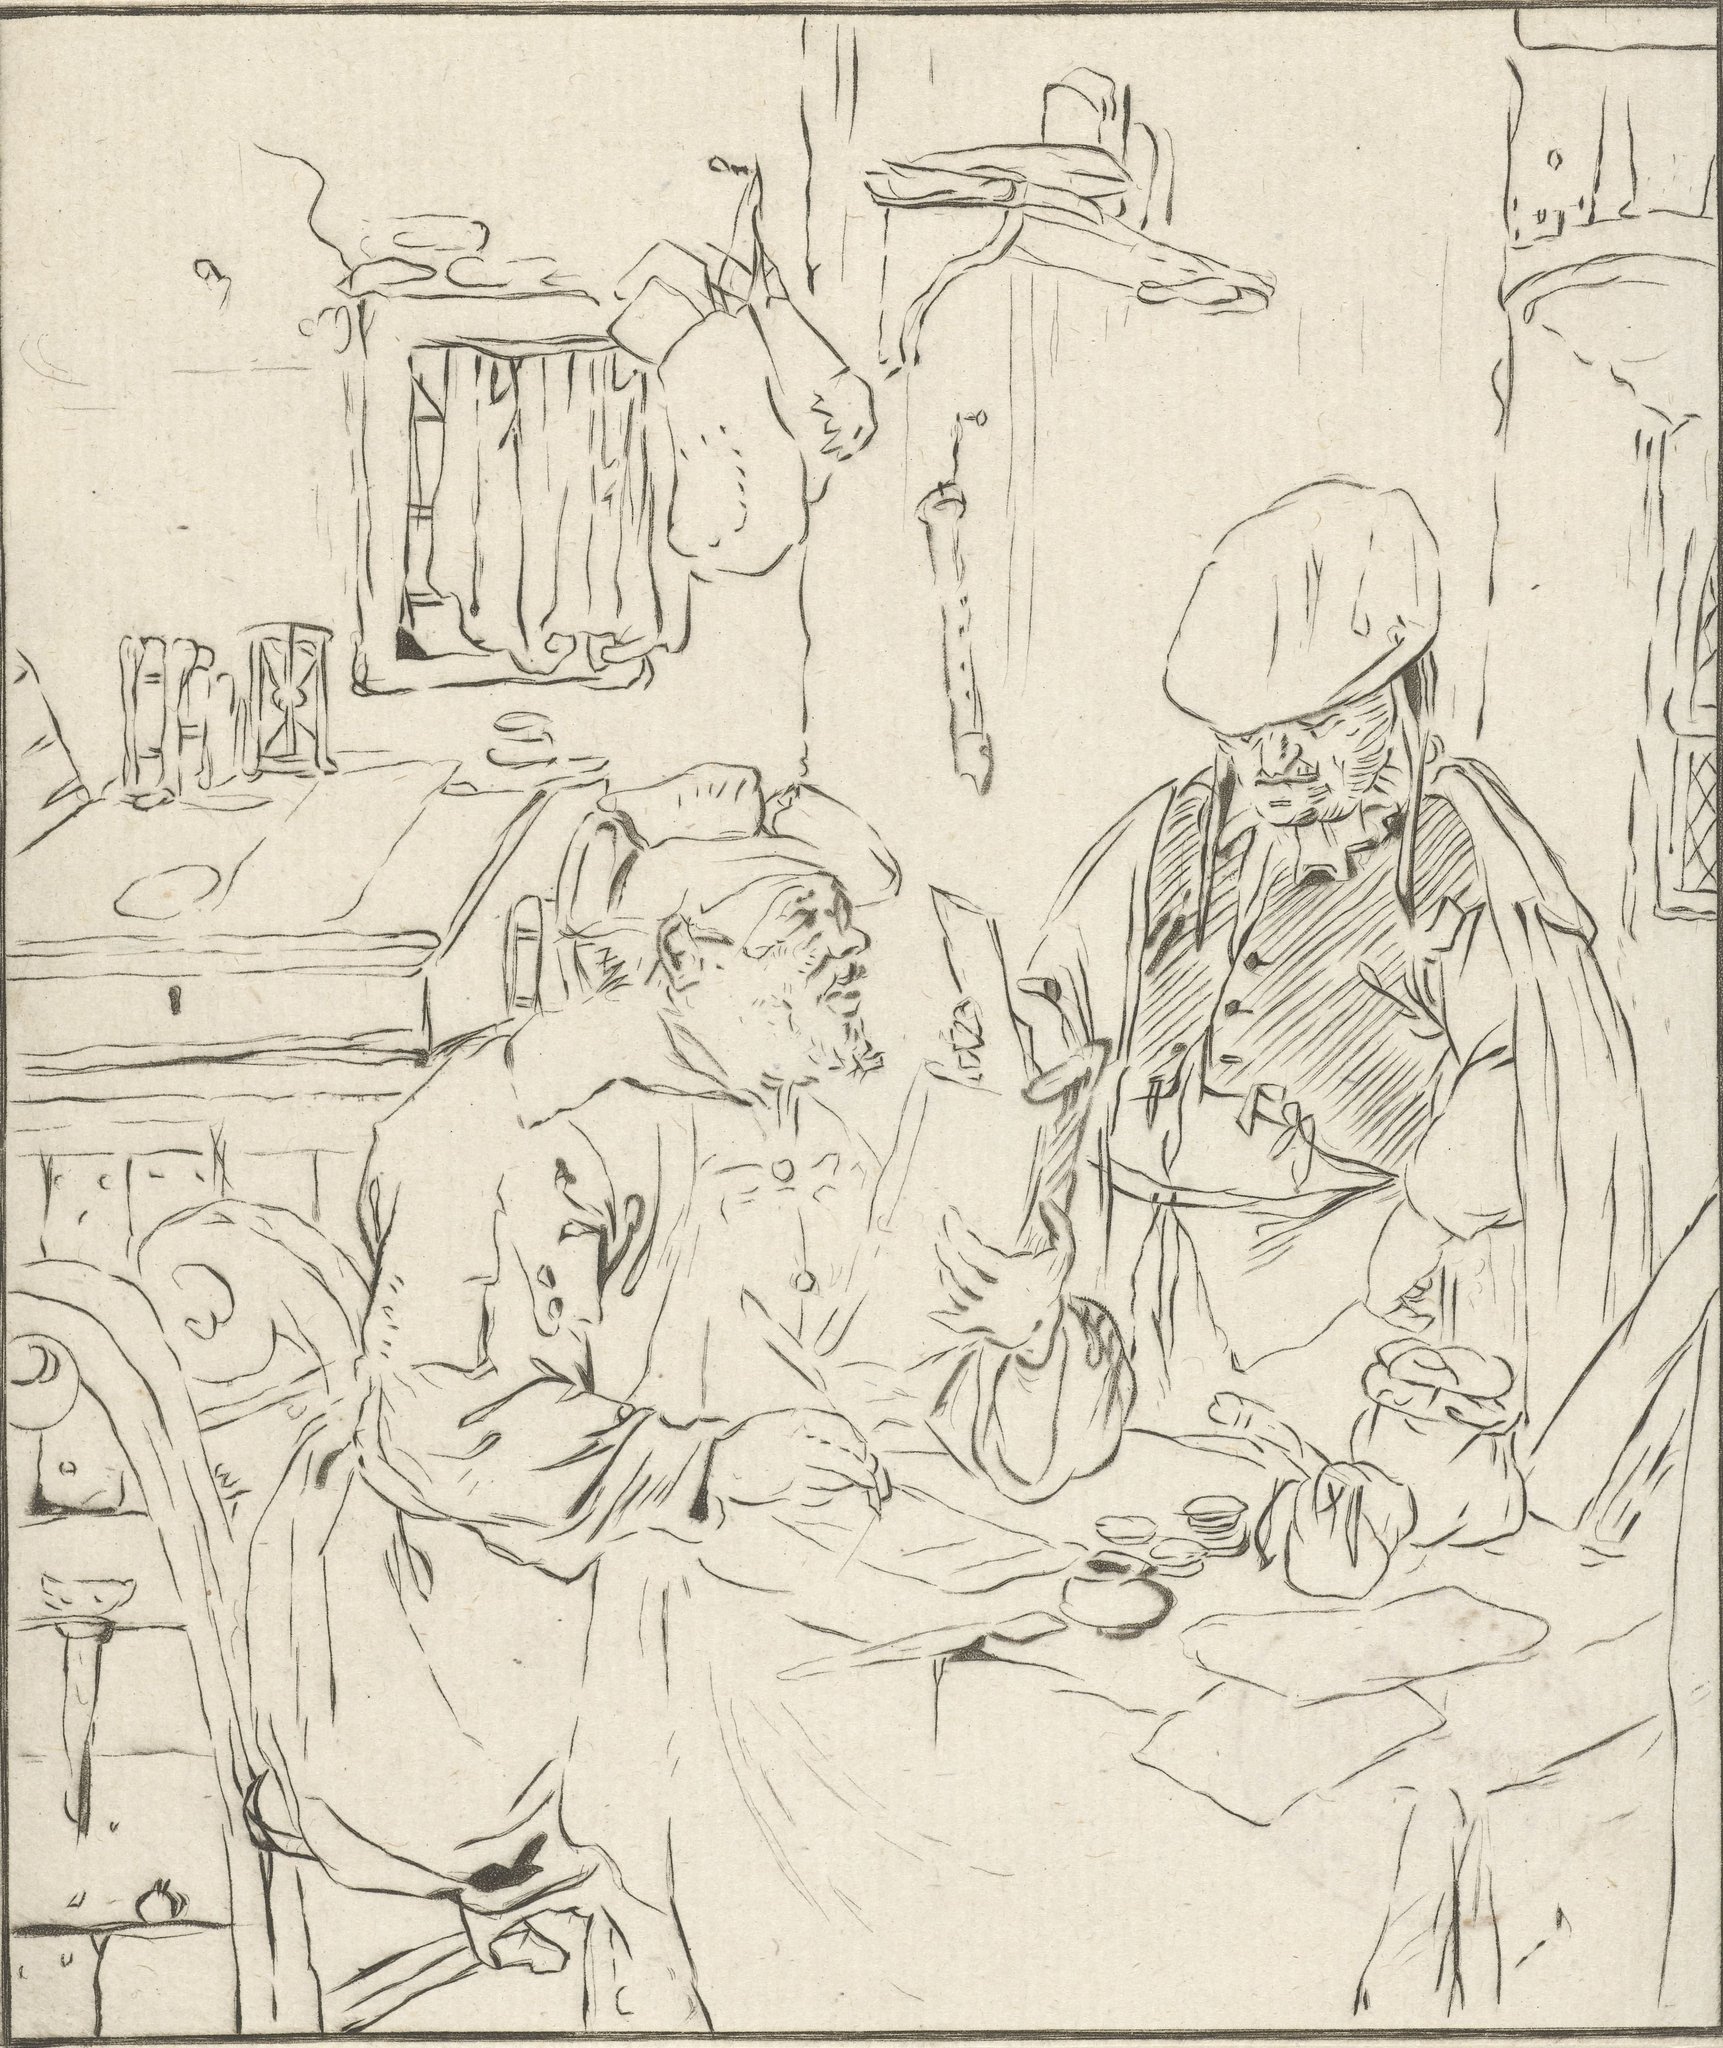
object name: print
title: Schrijver van een brief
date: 1777-1786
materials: paper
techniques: etching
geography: amsterdam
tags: sitting figure, writing tools, letter, envelope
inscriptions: collector's mark: Lugt 240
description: Een man, zittend aan een tafel, schrijft een brief. Naast hem staat een man met een brief in de hand.